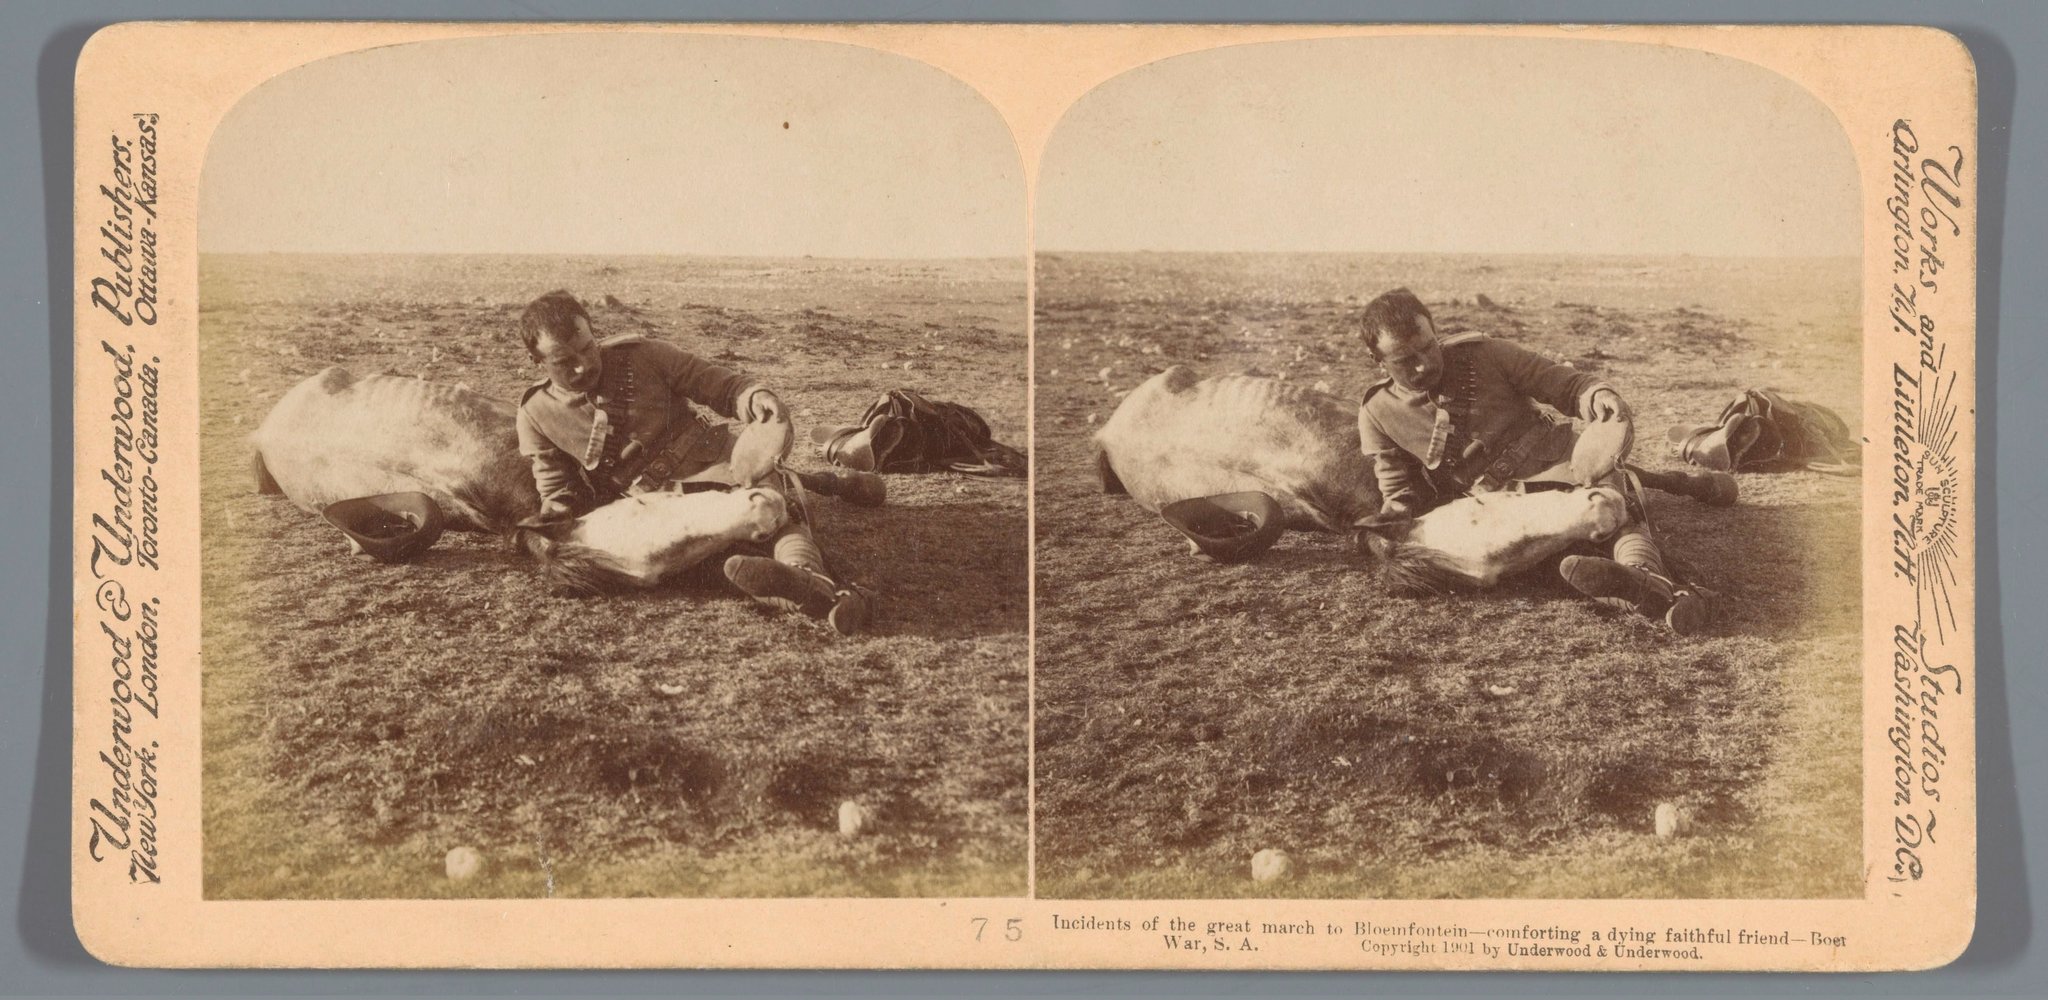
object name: stereograph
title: Incidents to the great march to Bloemfontein - comforting a dying faithful friend - Boer War, S.A.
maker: Anonymous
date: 1901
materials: cardboard, paper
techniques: albumen print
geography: new york city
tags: the soldier; the soldier's life, horse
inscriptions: inscription: ‘Works and Studios ~/ Arlington, N.J. Littleton, N.H. Washington, D.C.’, number: ‘75’, inscription, copyright notice: ‘Copyright 1901 by Underwood & Underwood.’